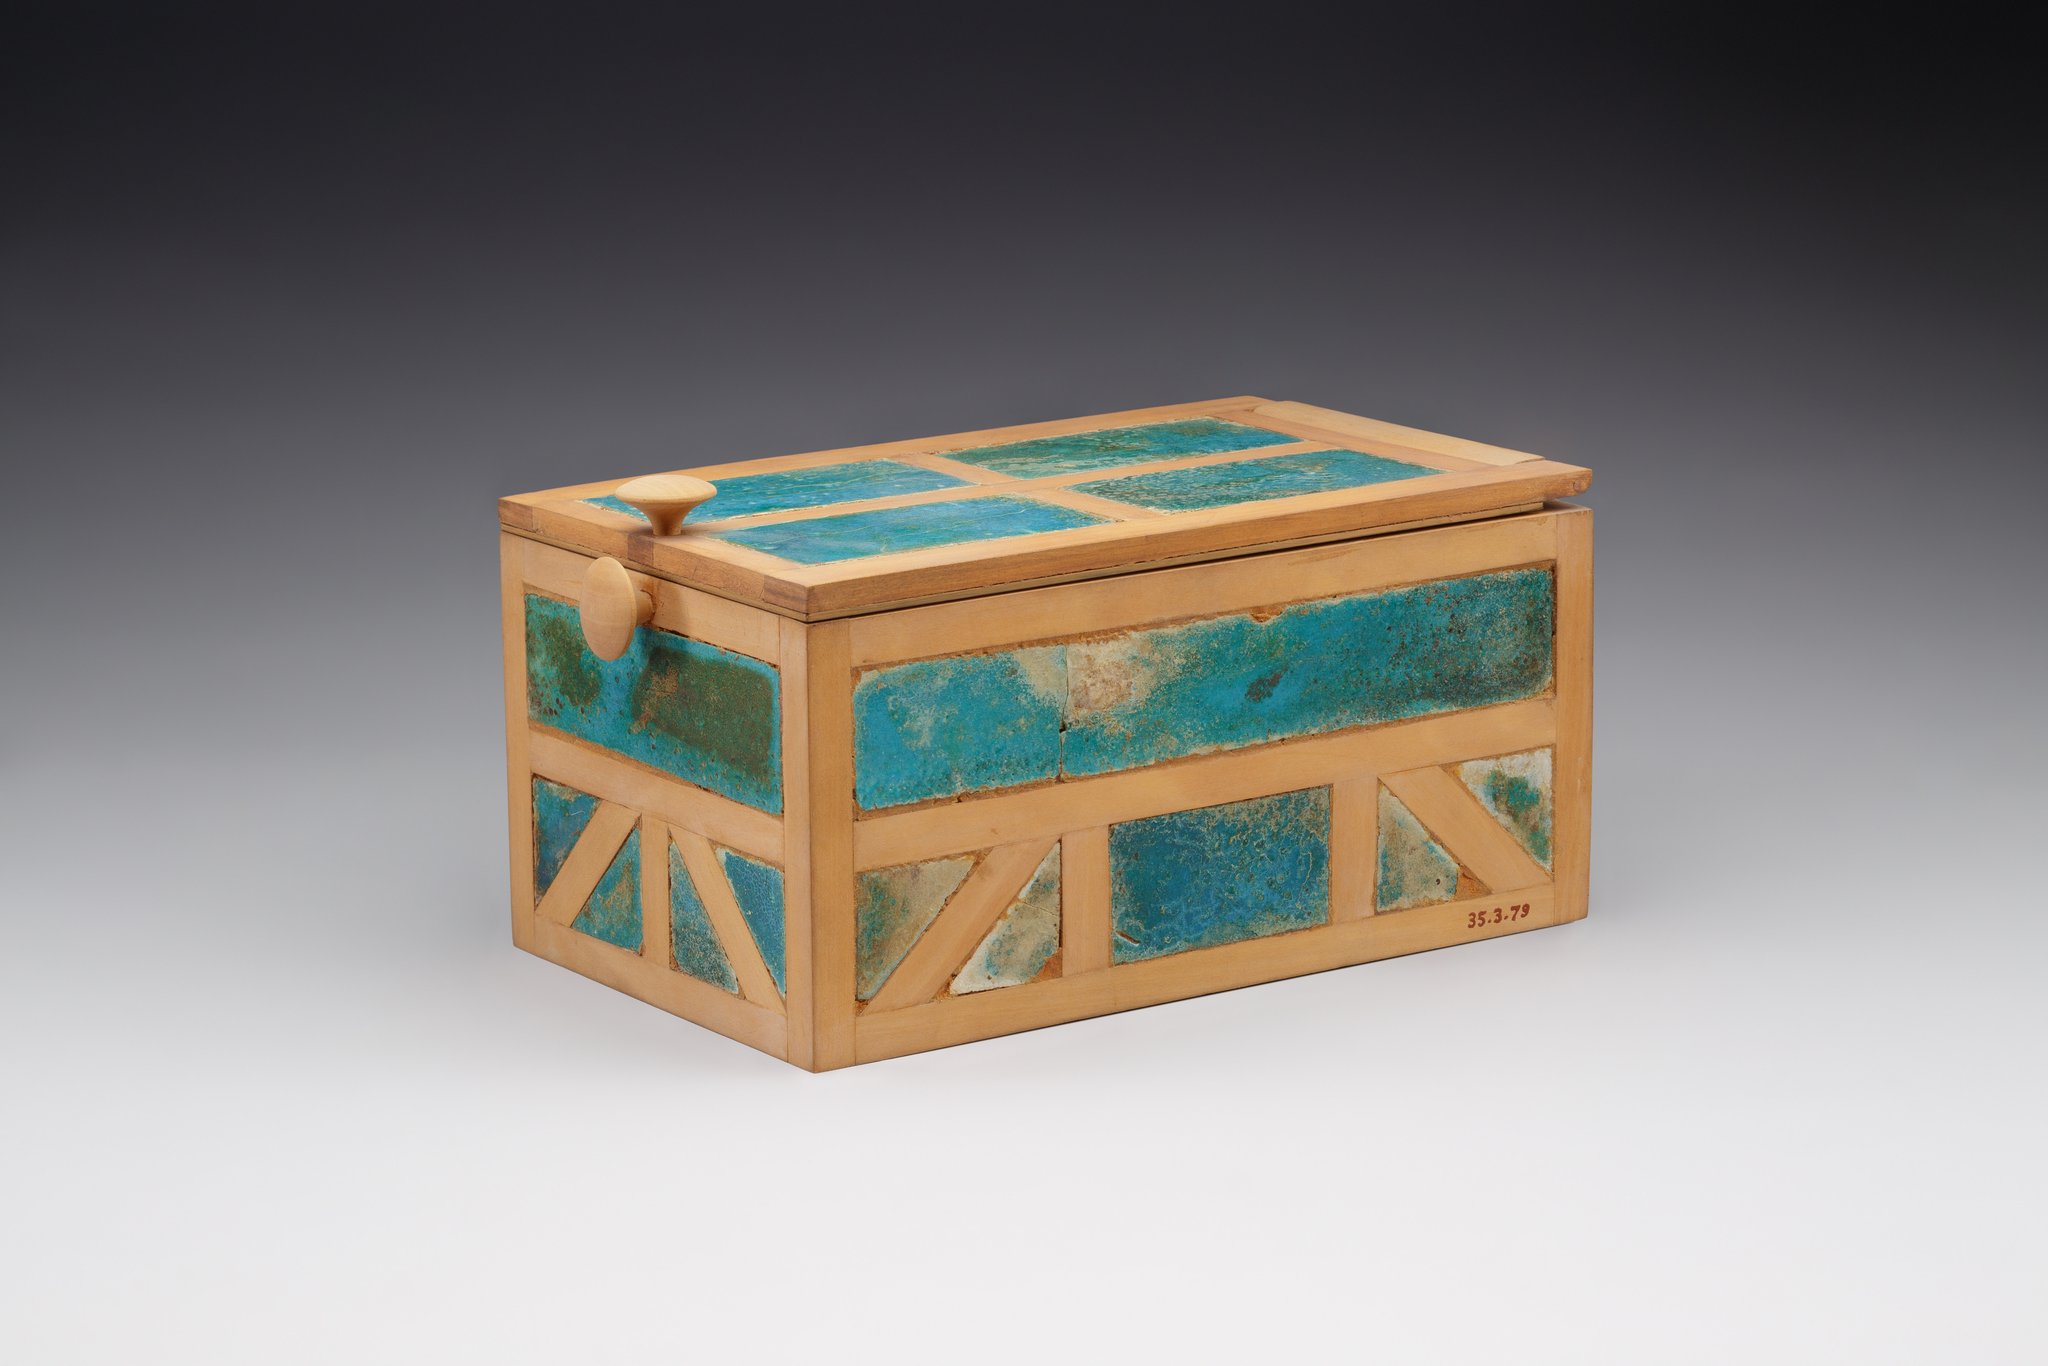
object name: box, jewelry, rennefer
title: Jewelry Box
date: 1504-1447 BCE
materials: faience, wood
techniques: inlay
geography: egypt